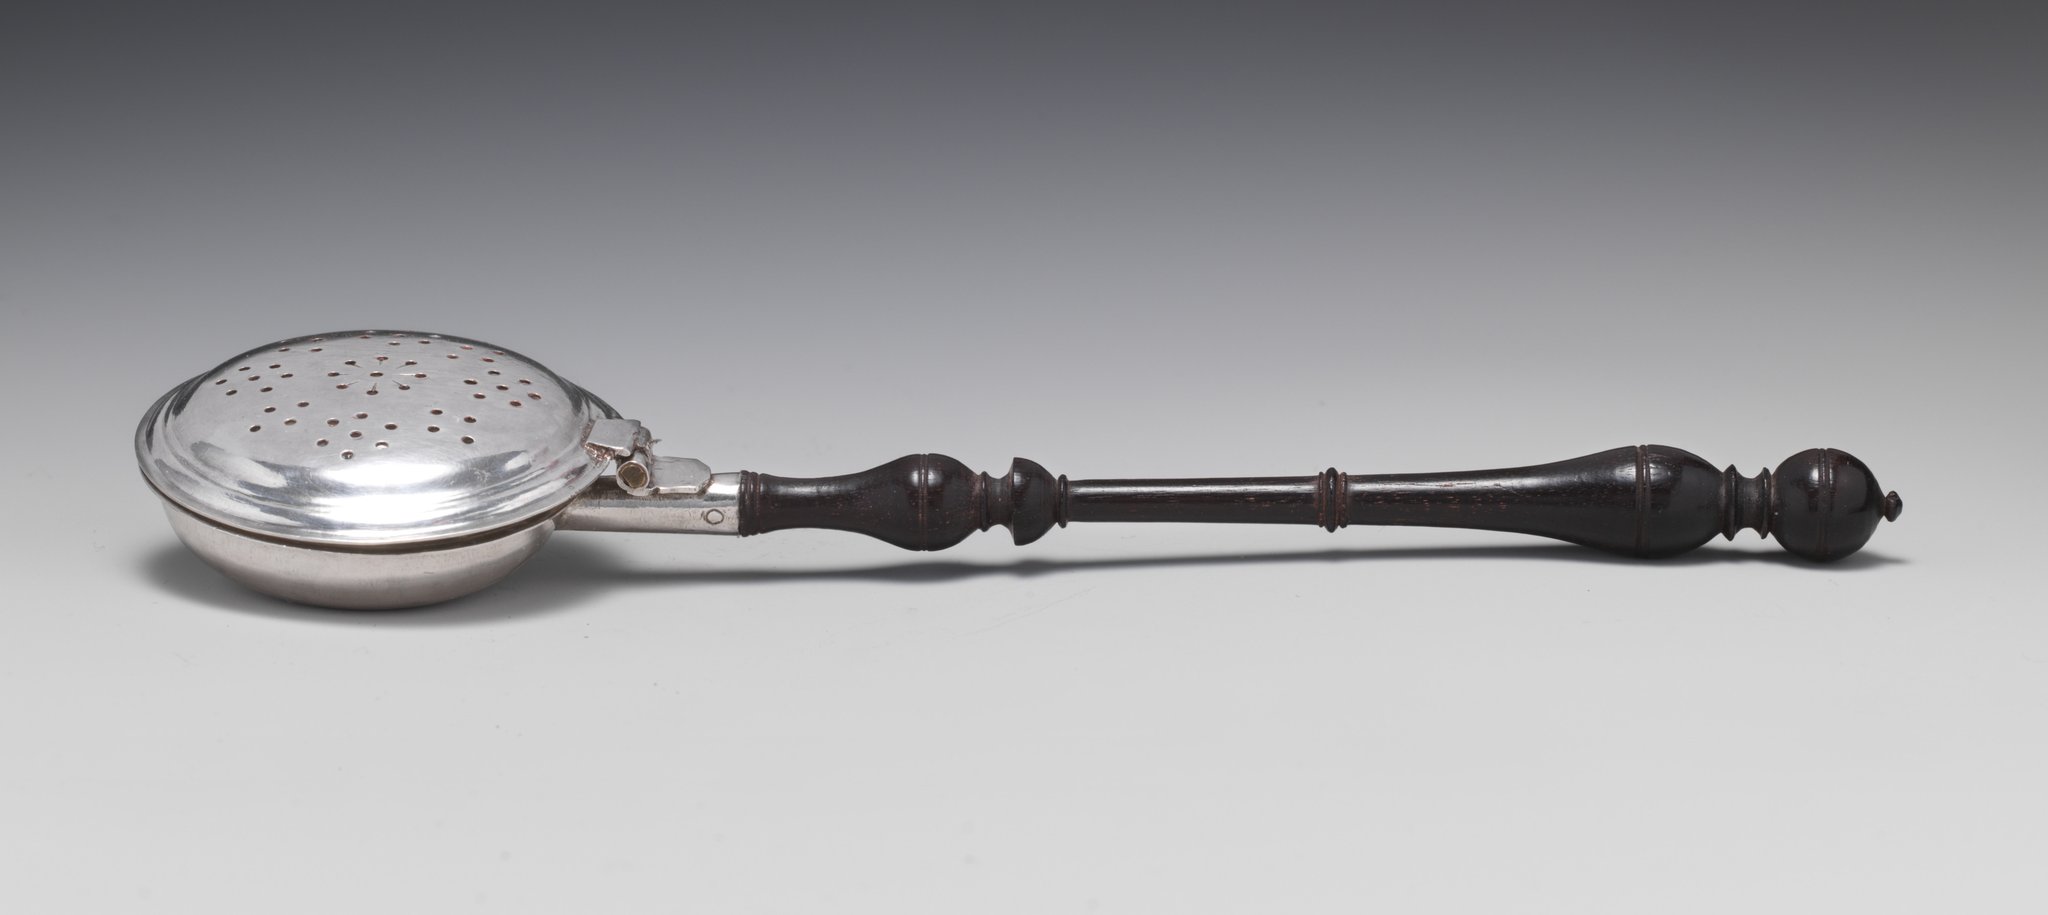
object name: warming pan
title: Miniature warming pan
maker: david clayton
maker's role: artist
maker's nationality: british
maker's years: 1659-1719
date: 1720-1730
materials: silver, wood